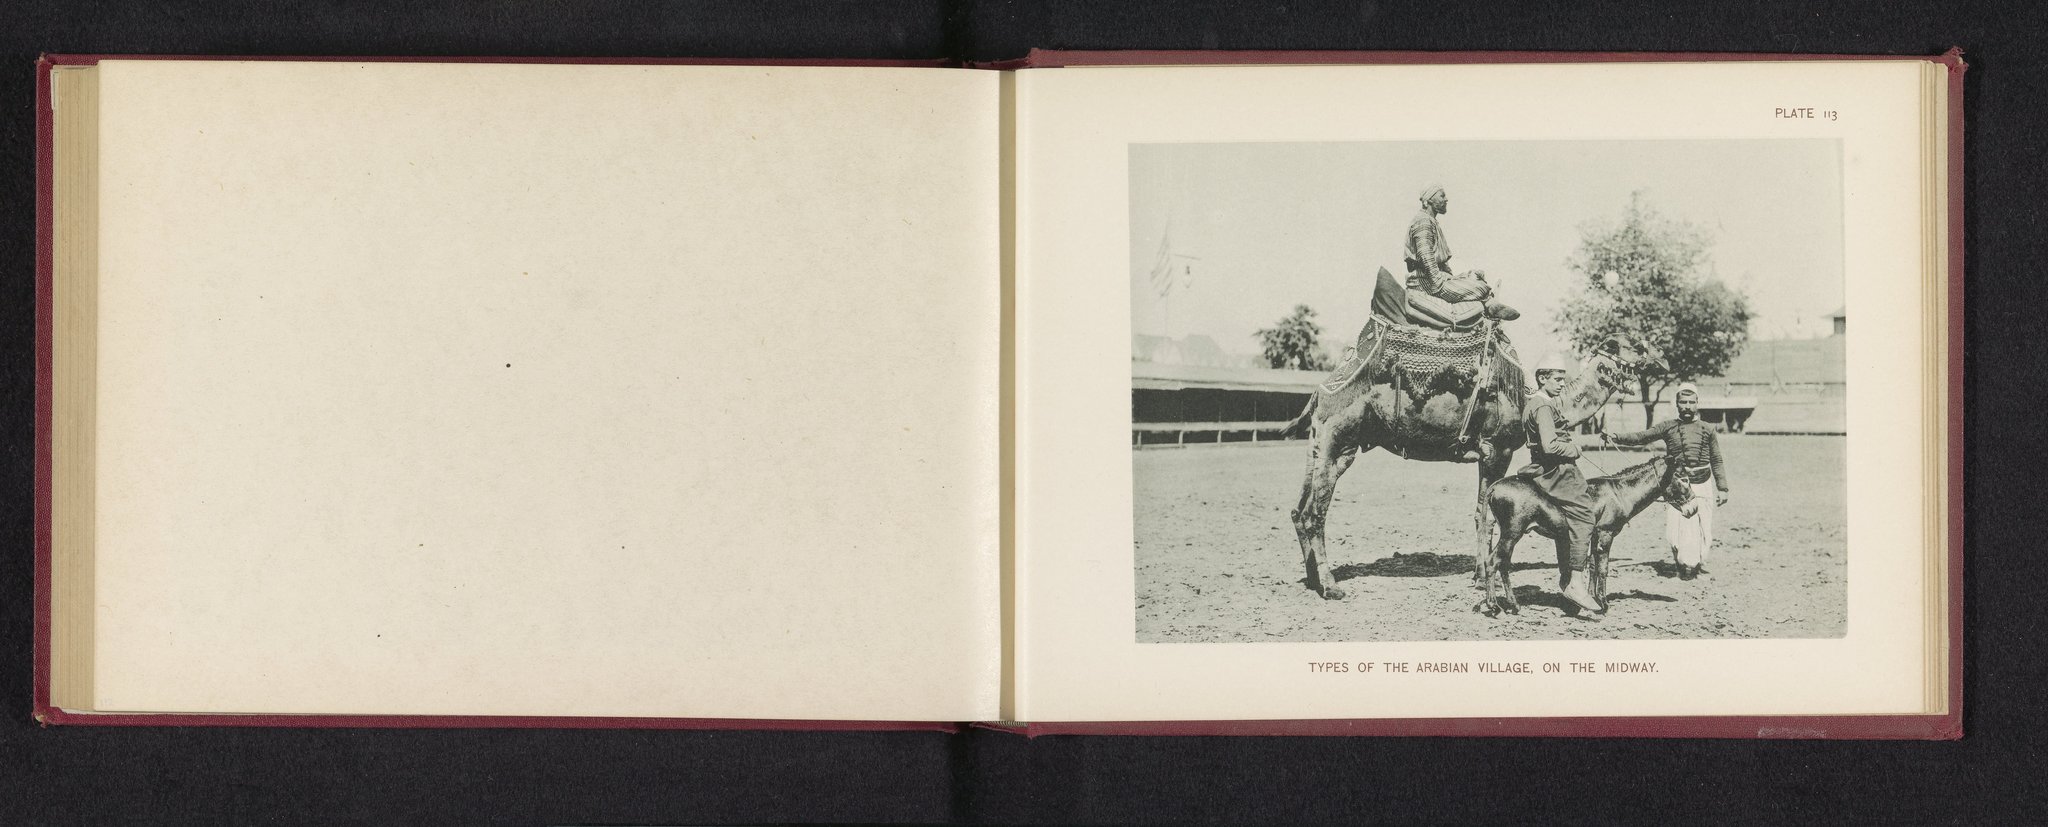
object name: page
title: Types of the Arabian village, on the Midway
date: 1893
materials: paper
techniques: photograph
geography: chicago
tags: hoofed animals: camel, ass, donkey, world fair, world exhibition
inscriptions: number: ‘Plate 113’